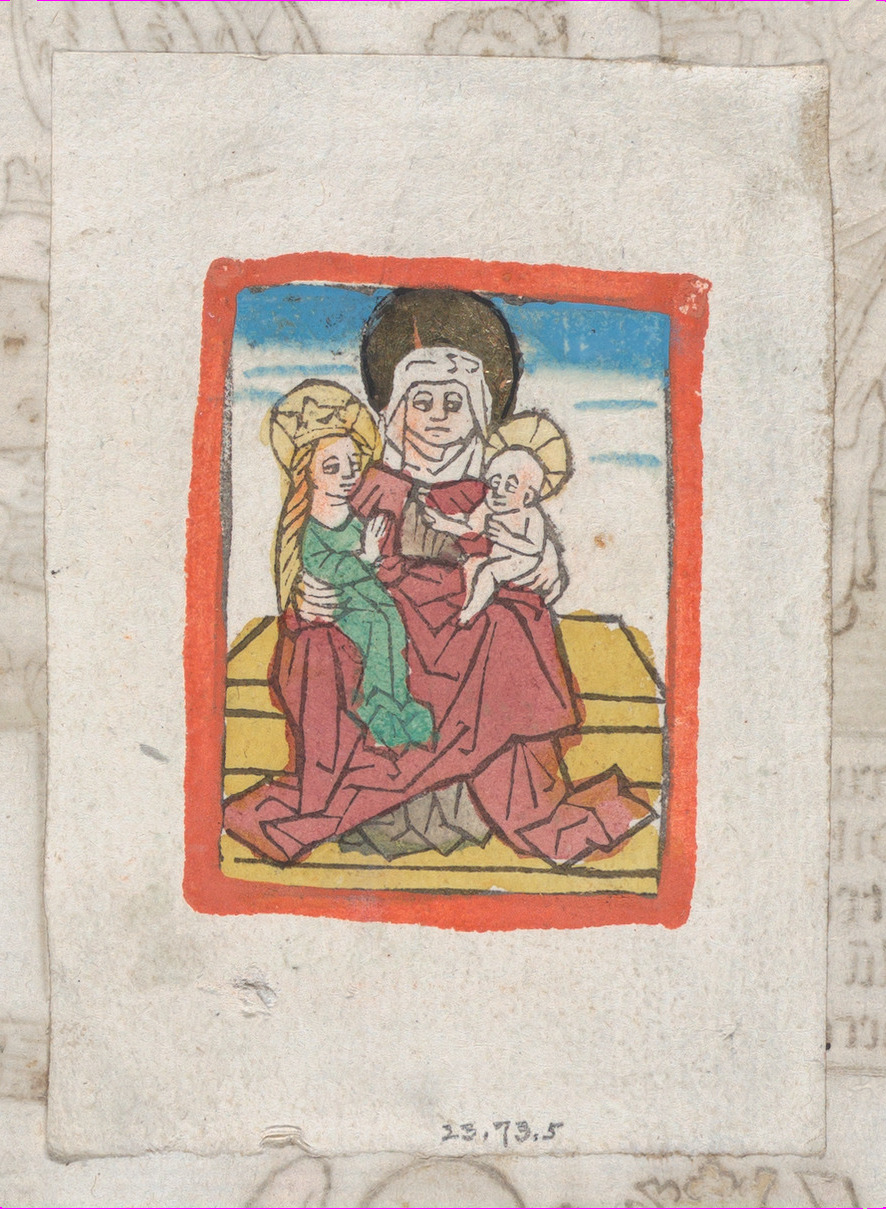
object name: print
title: St. Anne with the Virgin and the Christ Child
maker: anonymous, german, 15th century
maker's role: artist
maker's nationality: german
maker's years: 1400-1500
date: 1450-1460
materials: gold leaf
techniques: hand coloring, woodcut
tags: christ,saint anne,virgin mary